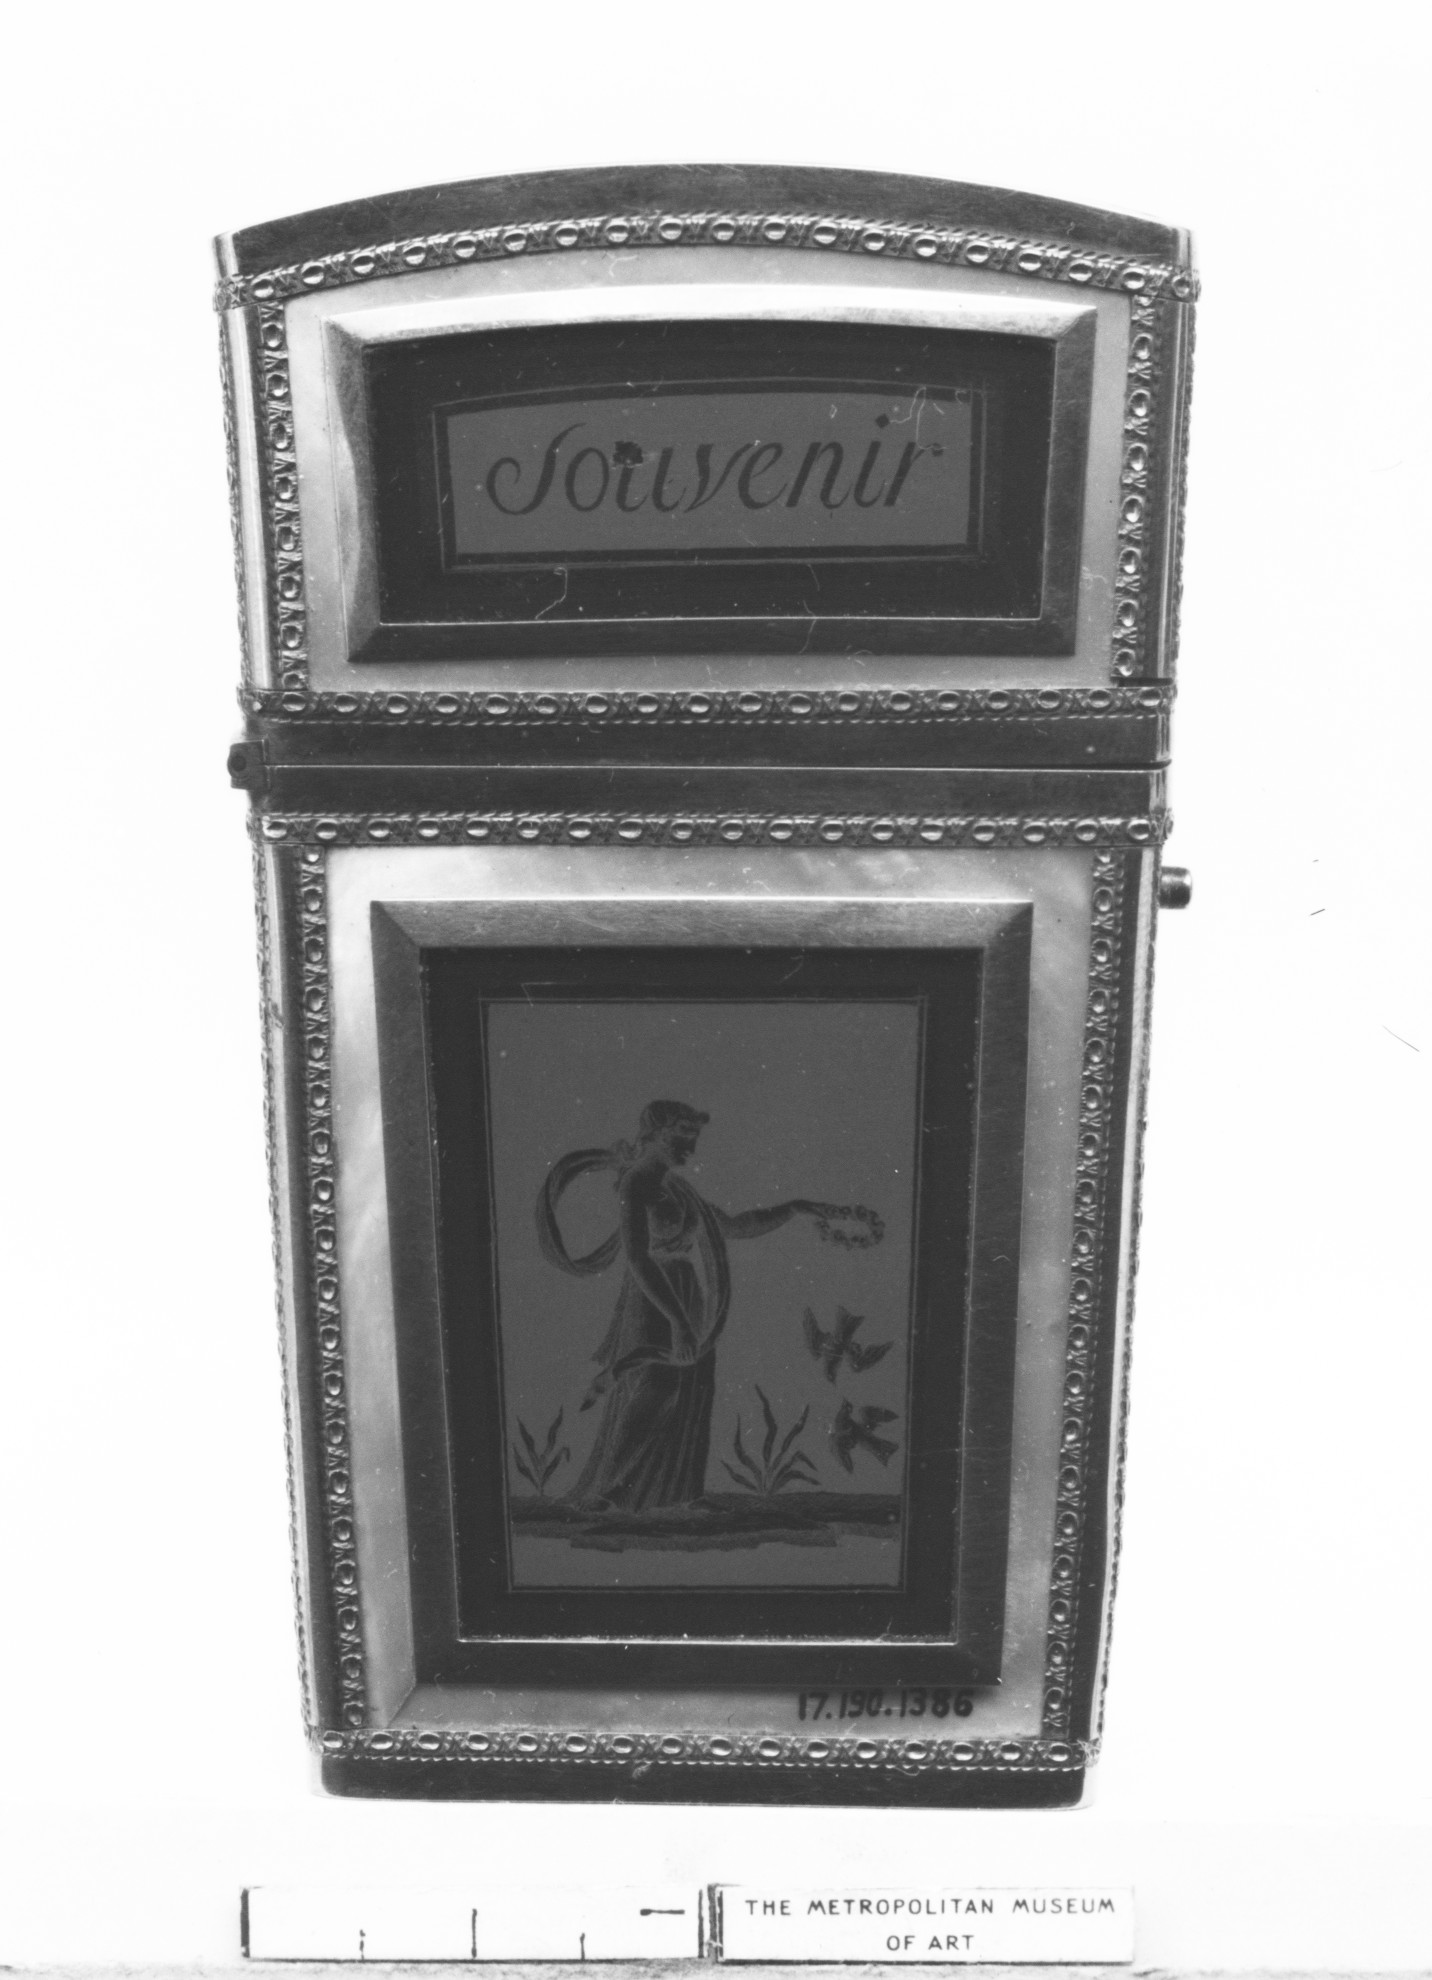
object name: souvenir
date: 1795-1799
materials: gold, ivory, mother of pearl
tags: birds,women